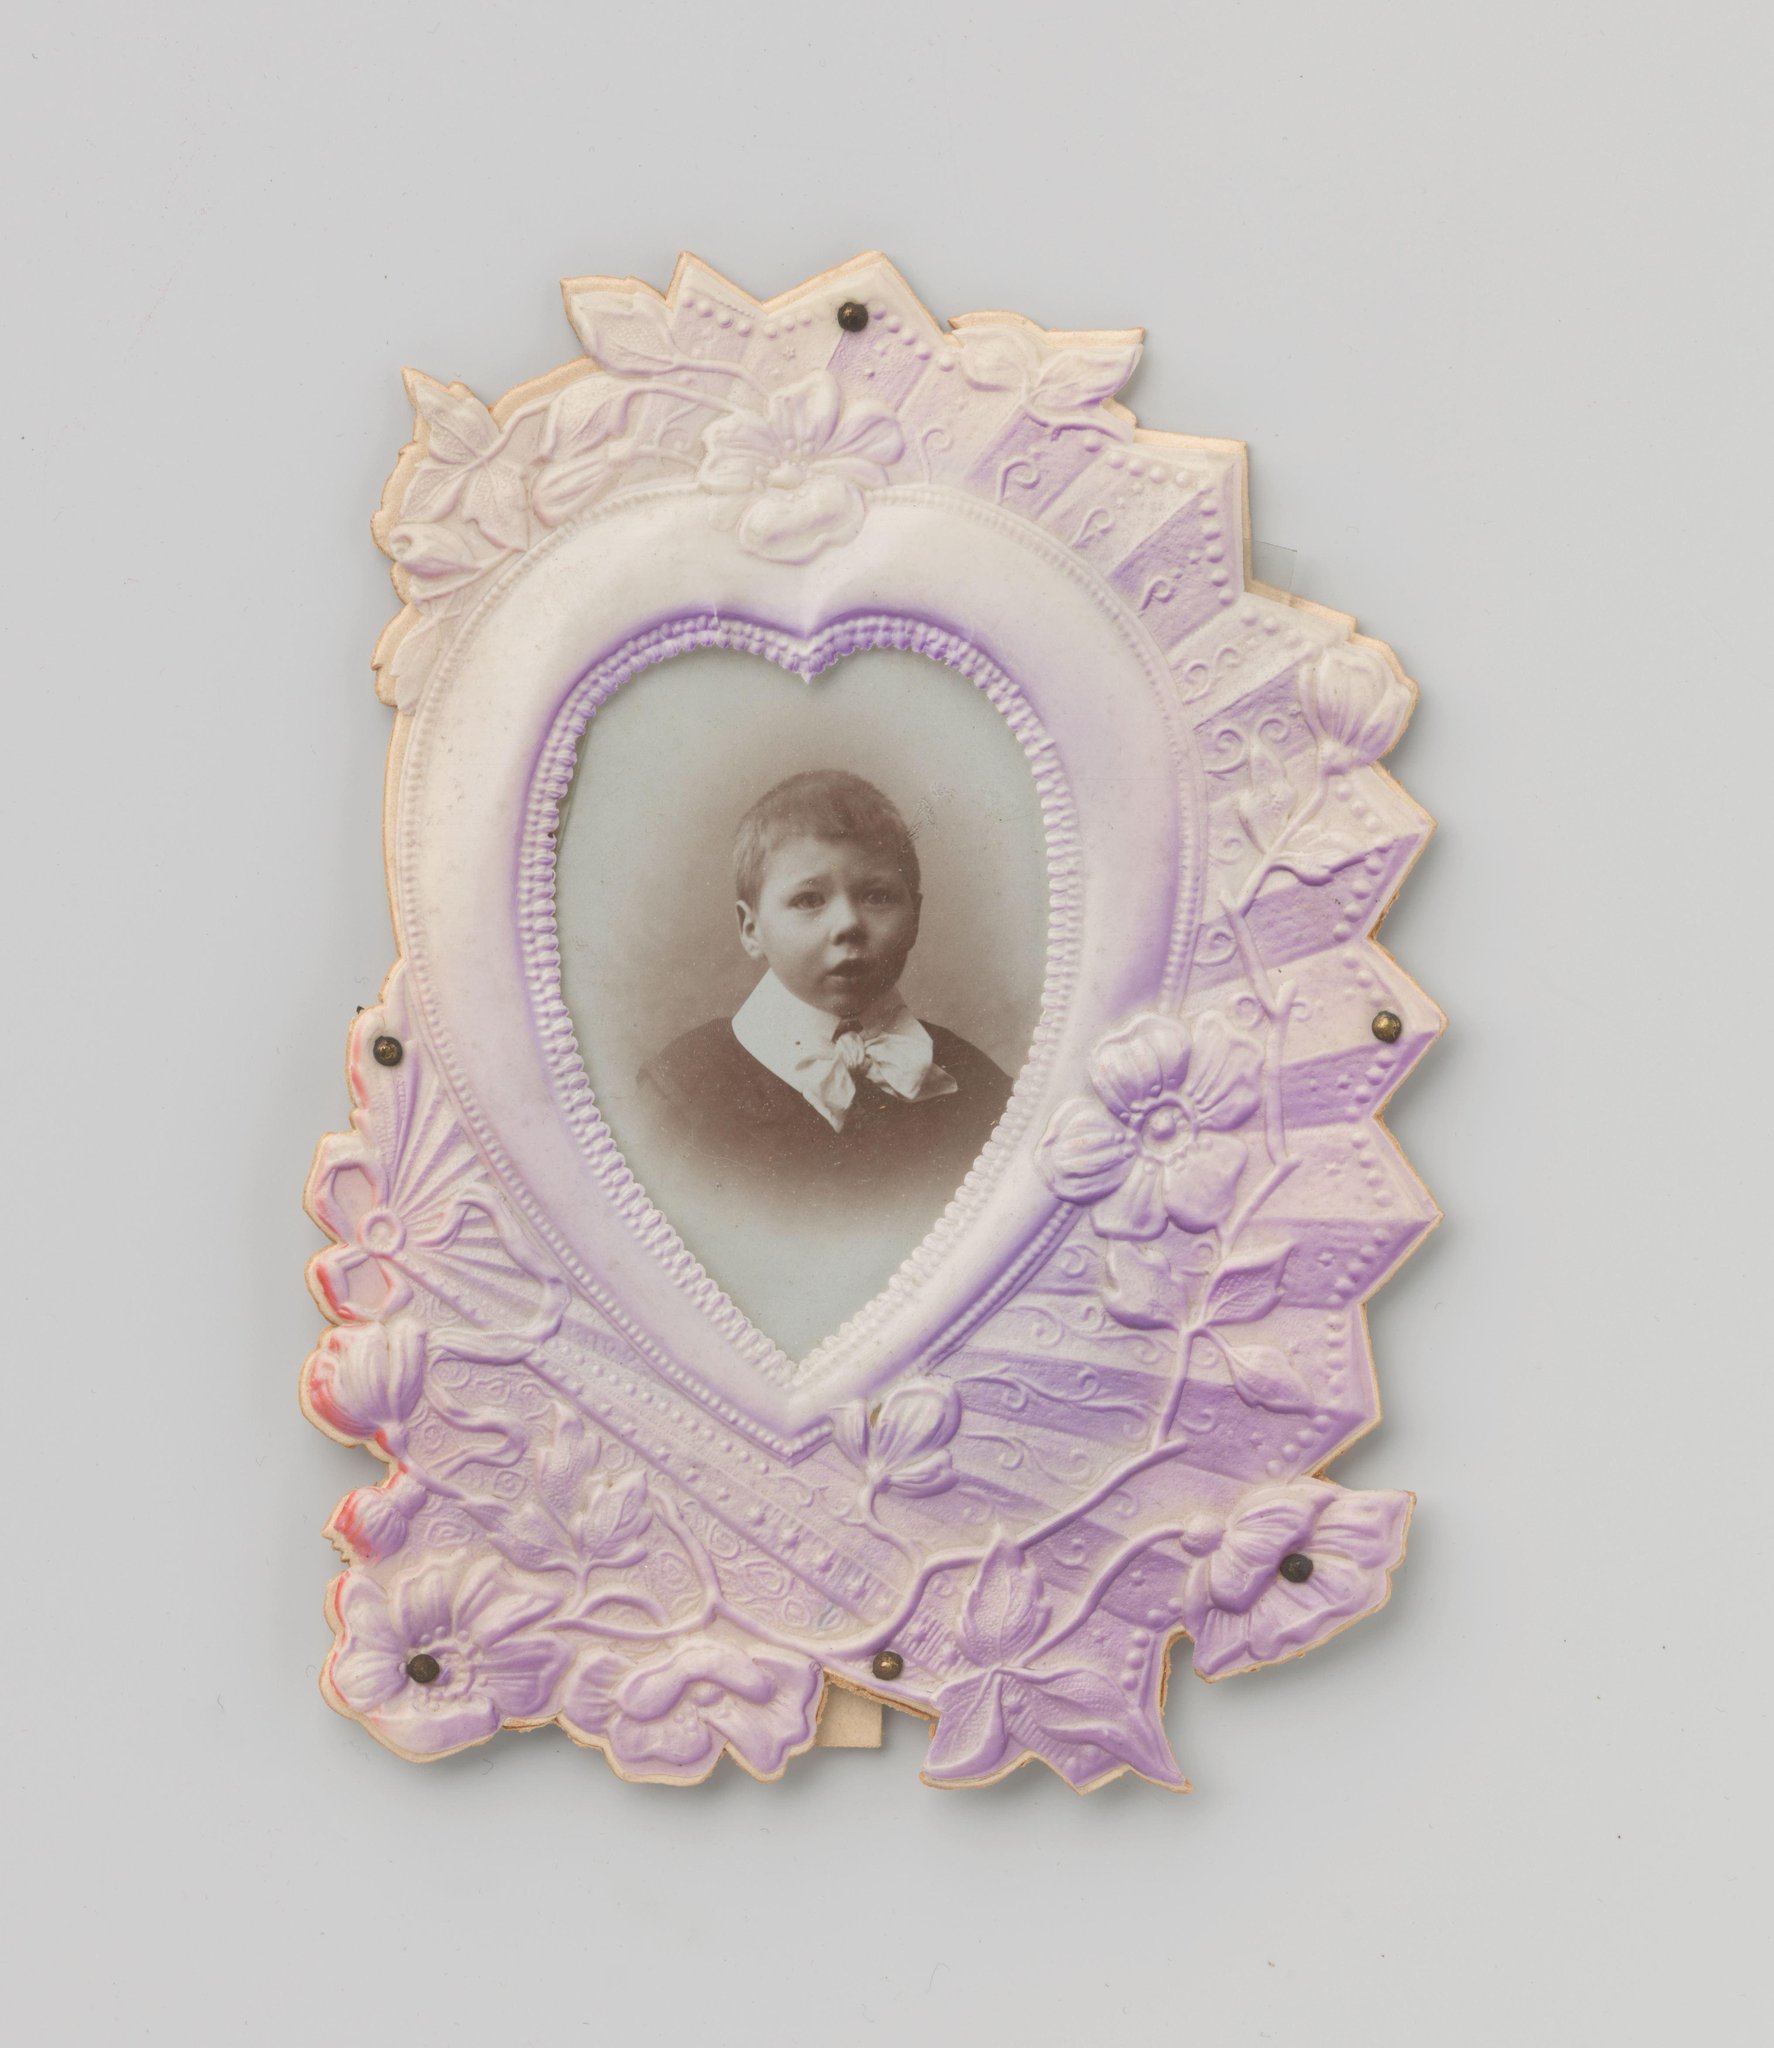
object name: photograph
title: Portret van een onbekende jongen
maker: Anonymous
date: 1880-1900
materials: paper, cardboard, glass, metal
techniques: collodion silver print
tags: boy (child between toddler and youth), anonymous historical person portrayed